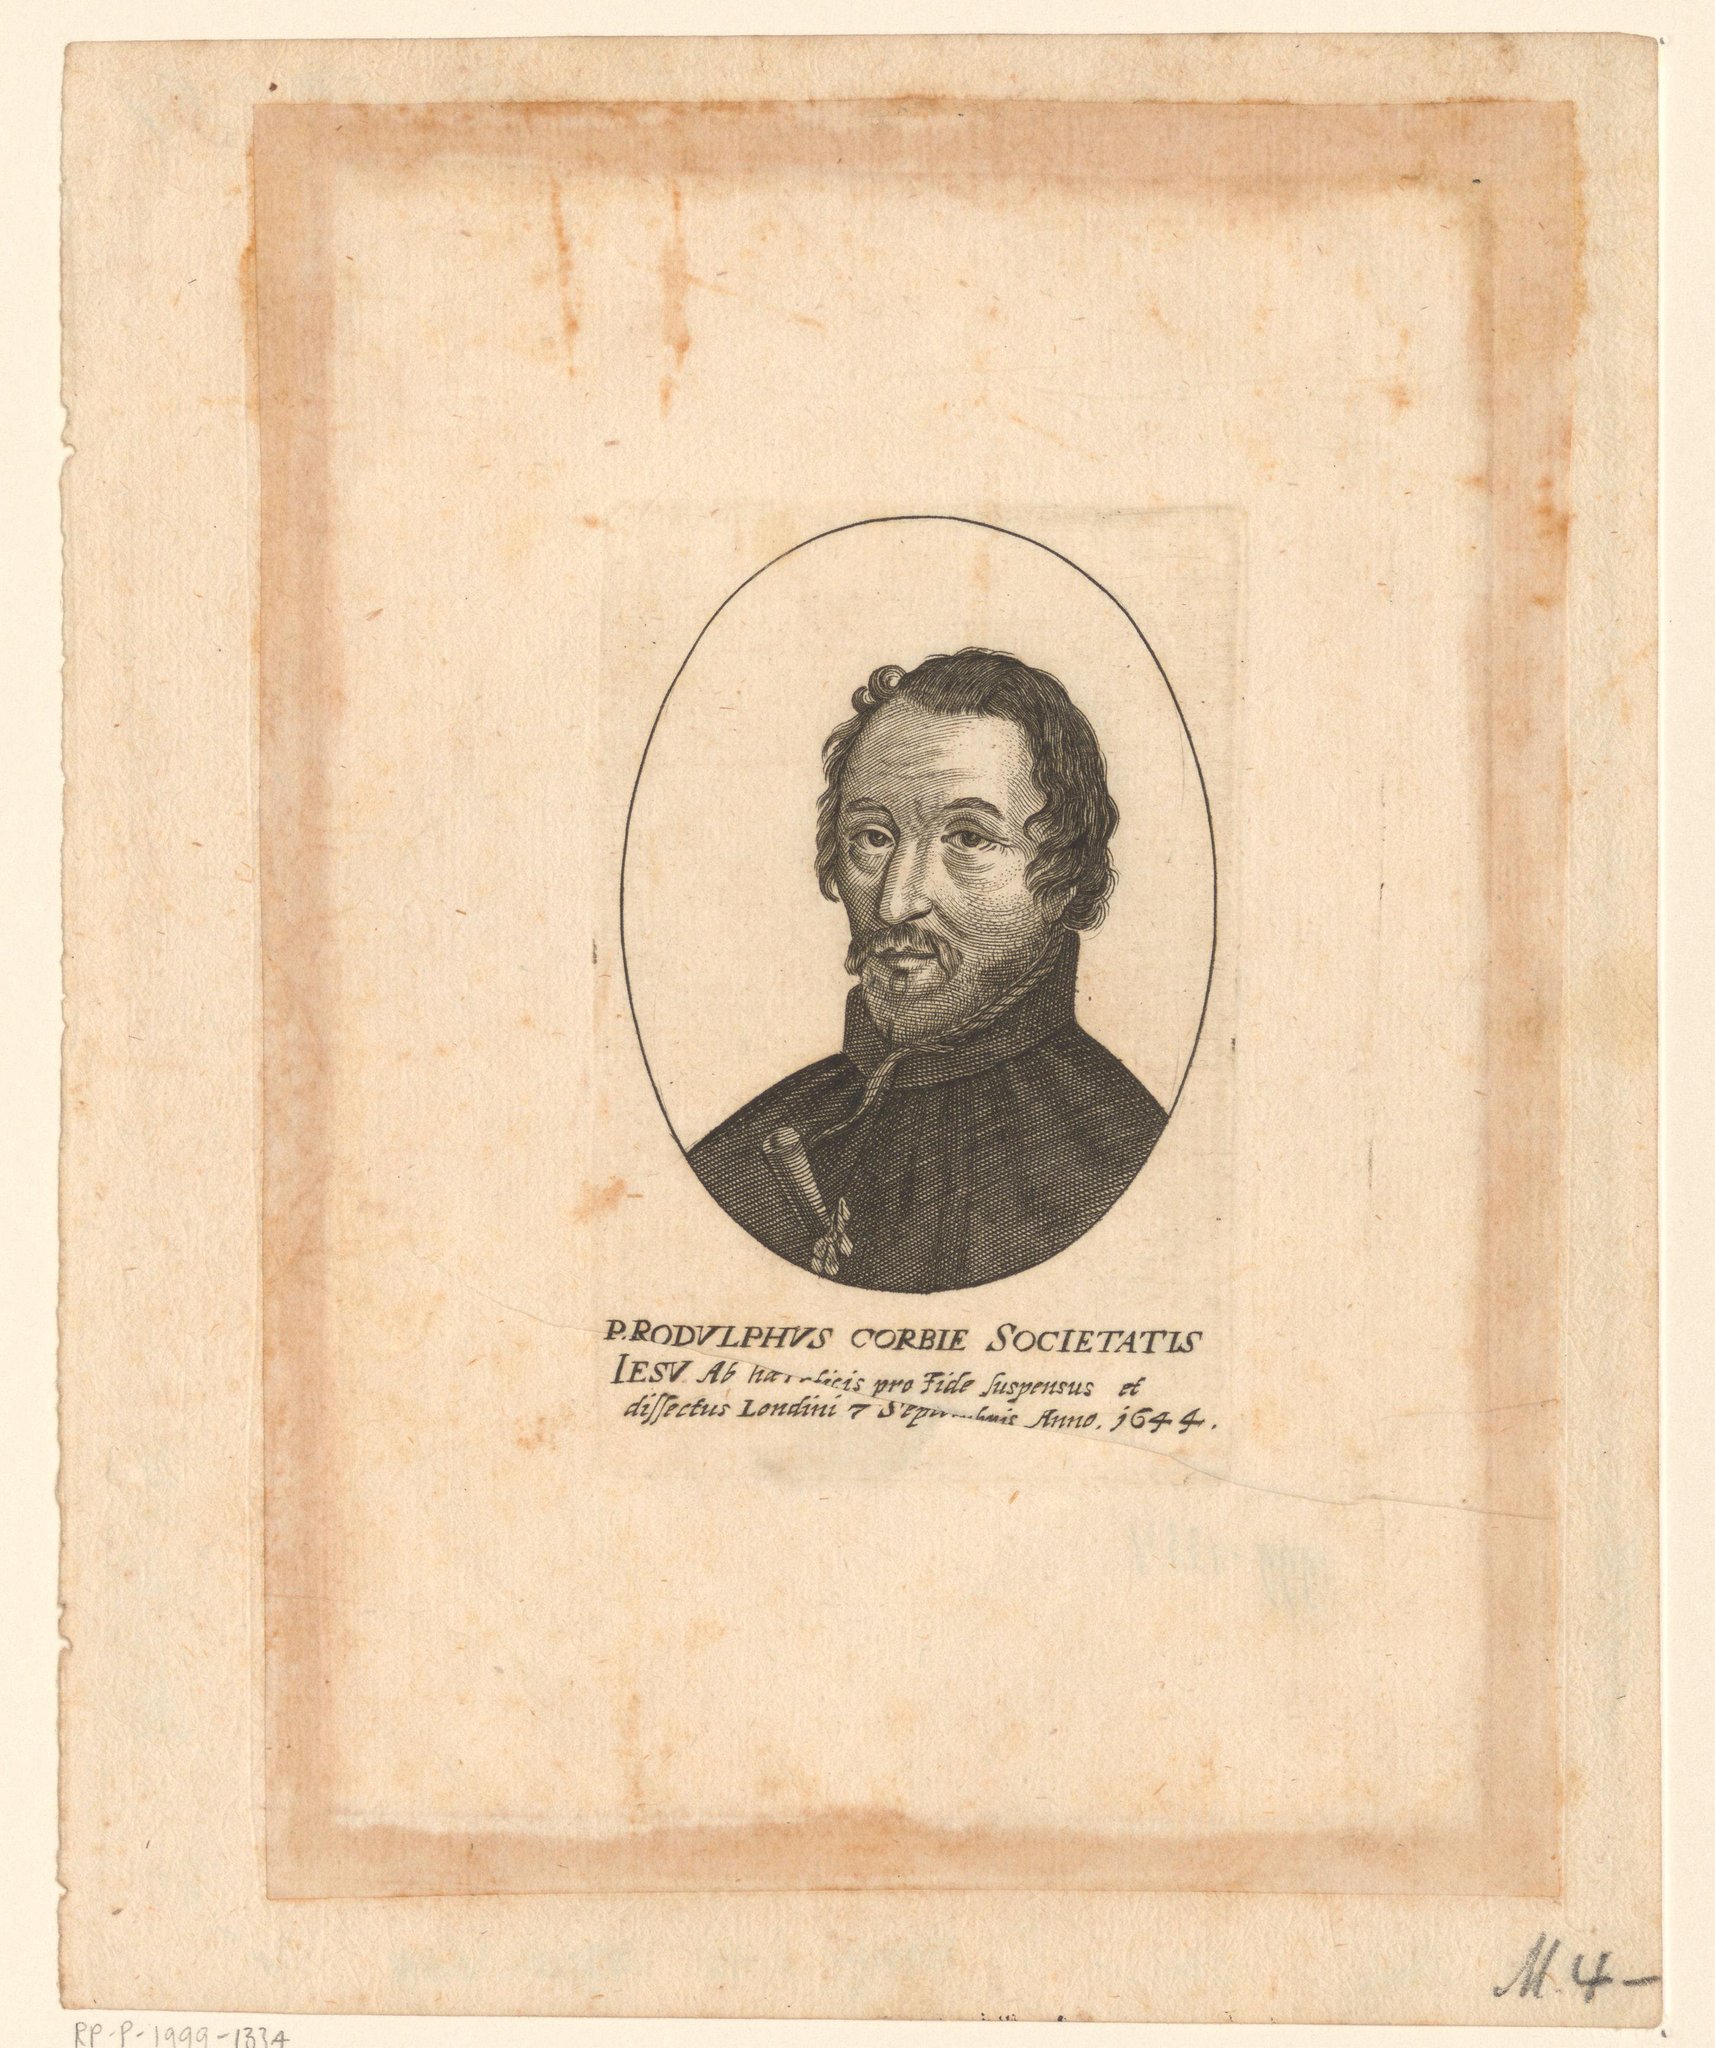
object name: print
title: Portret van Rodulphus Corbie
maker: Anonymous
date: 1644-1699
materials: paper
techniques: engraving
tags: historical persons